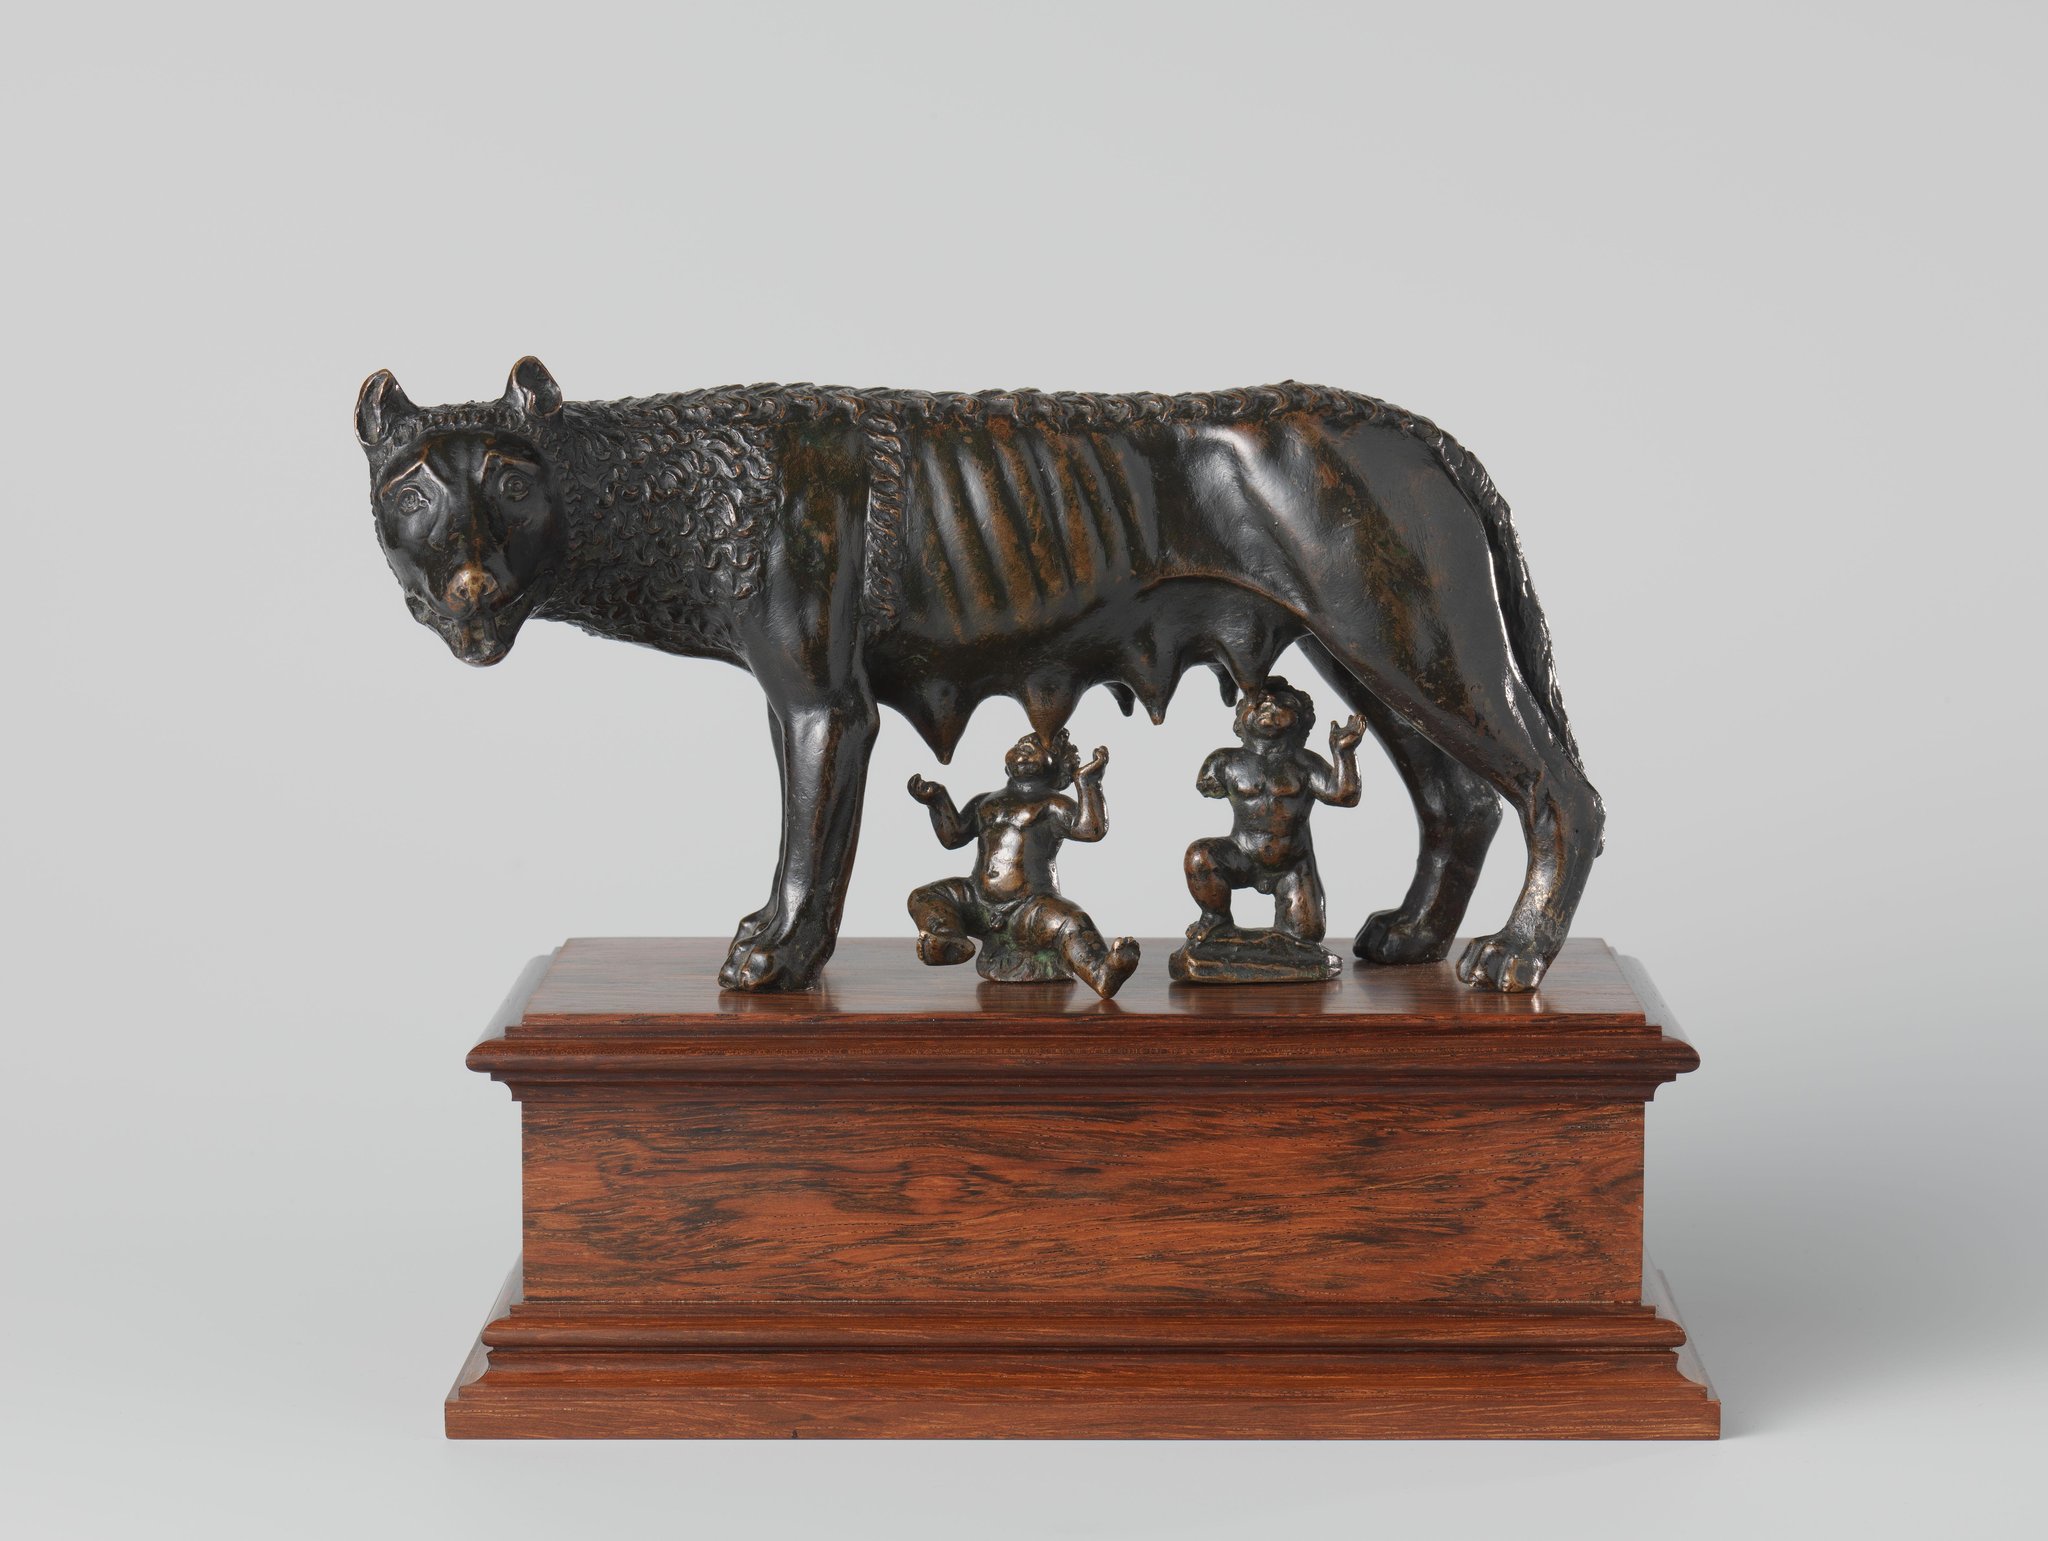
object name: figure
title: She-wolf with Romulus and Remus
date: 1500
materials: bronze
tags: romulus and remus are washed ashore and suckled by a she-wolf; 'lupa romana'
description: De wolvin staat met de kop naar links op de vier poten en zoogt beide knapen, die, met de handen omhoog, ieder afzonderlijk op een grondje zijn geplaatst; de een in zittende houding, de ander op één knie.